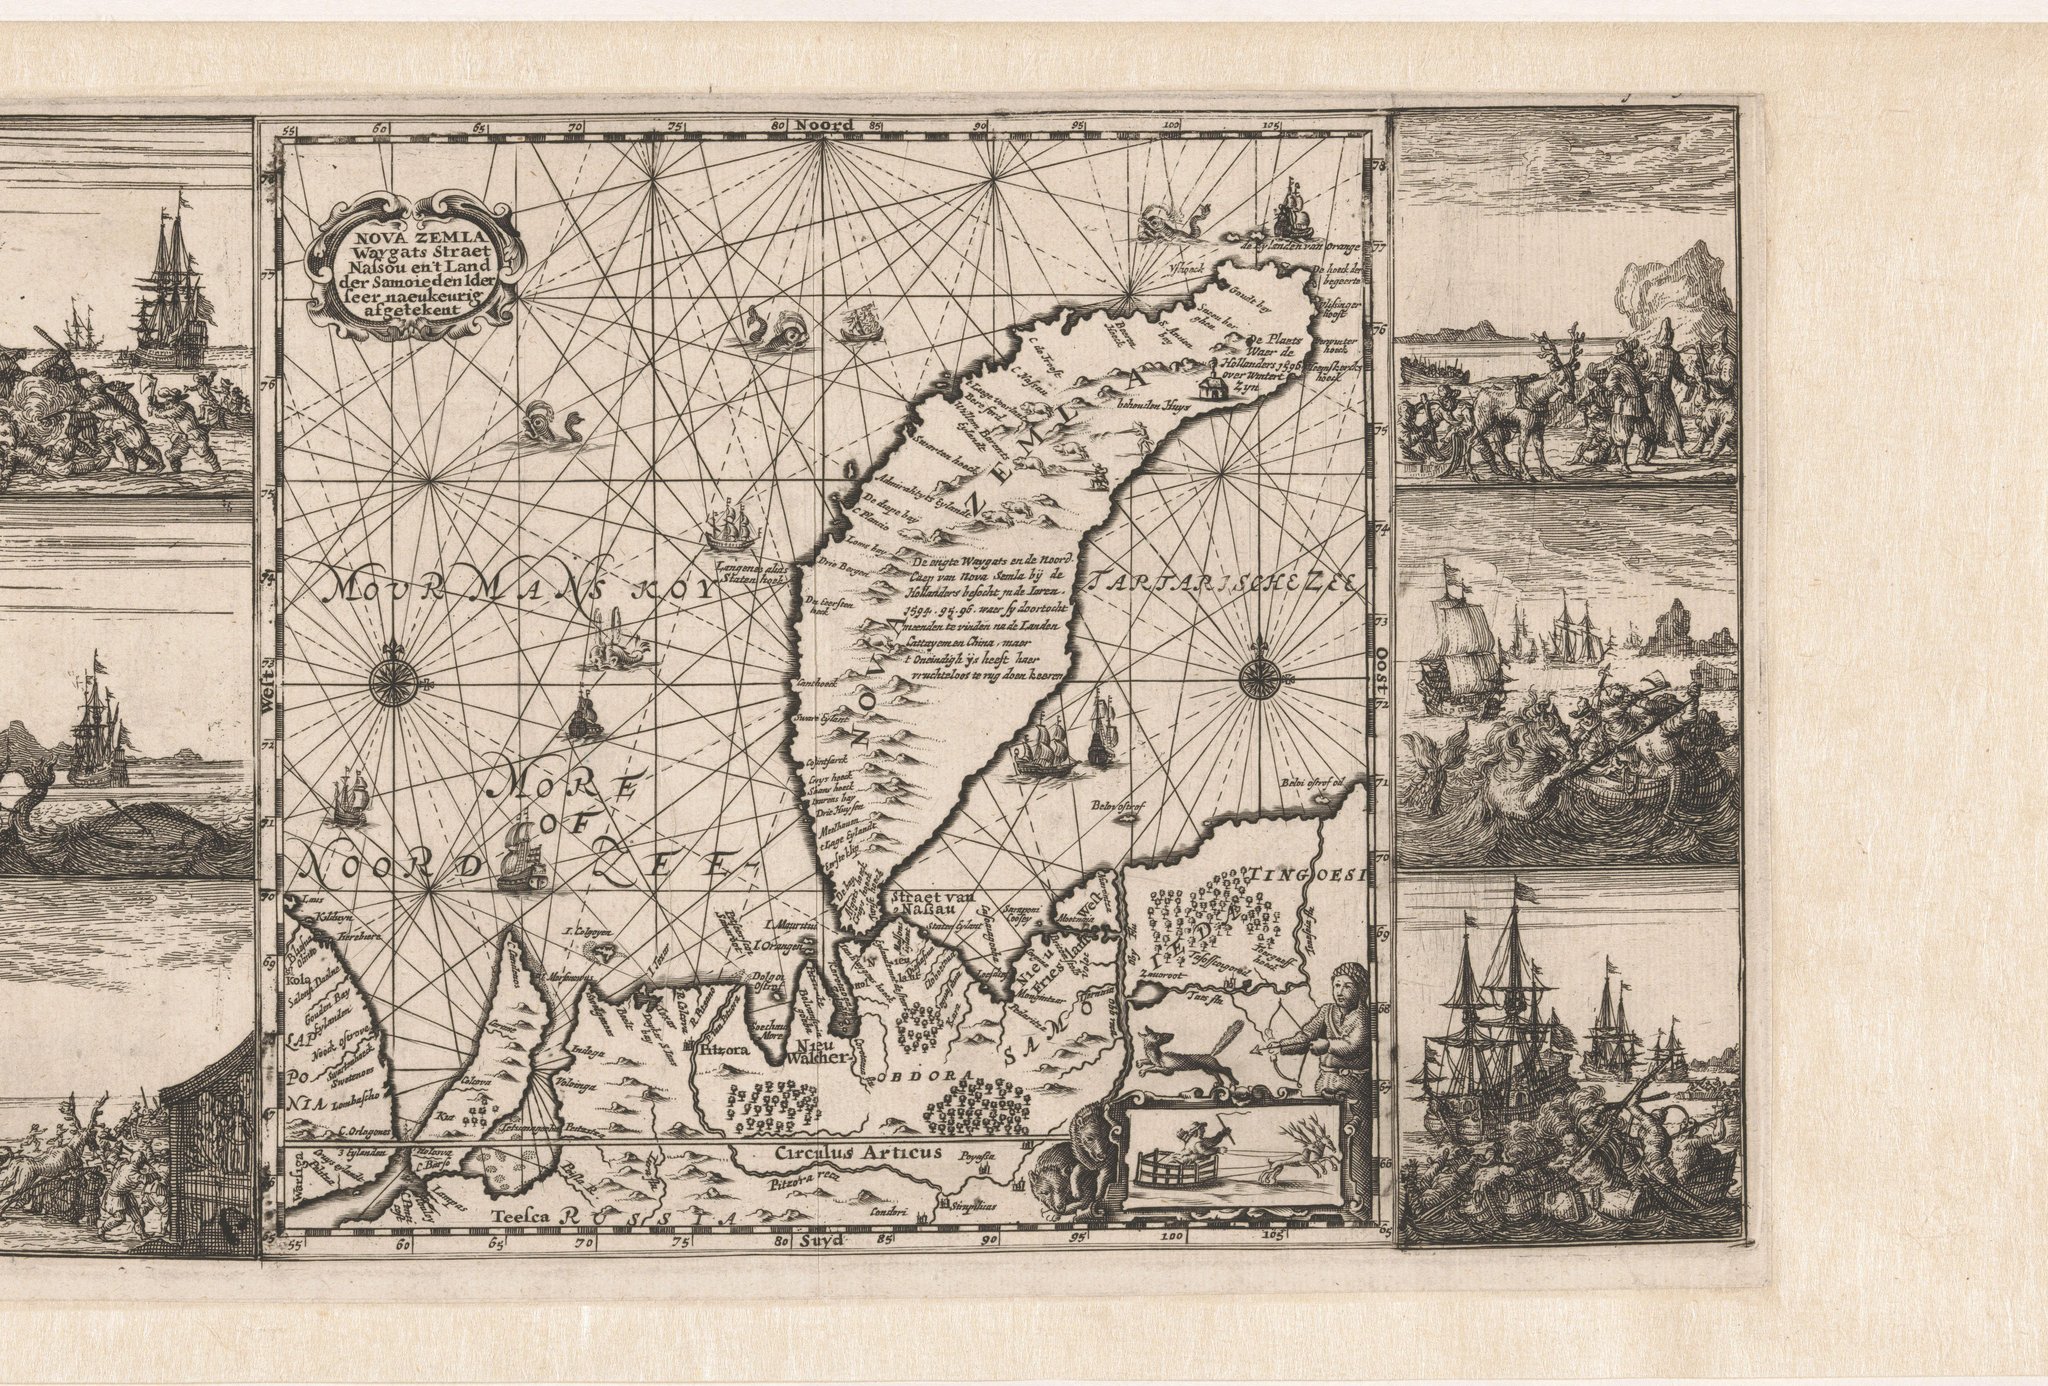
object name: history print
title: Kaartje van Nova Zembla met scènes uit de tocht, 1596-1597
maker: Anonymous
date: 1740-1760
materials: paper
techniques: engraving, etching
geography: northern netherlands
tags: willem barendsz., jacob van heemskerck, maps of separate countries or regions, landscapes in polar regions, exploration, expedition, voyage of discovery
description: Kaartje van Nova Zembla met aan de linker en rechter kant elk drie scènes uit de tocht, 1596-1597.